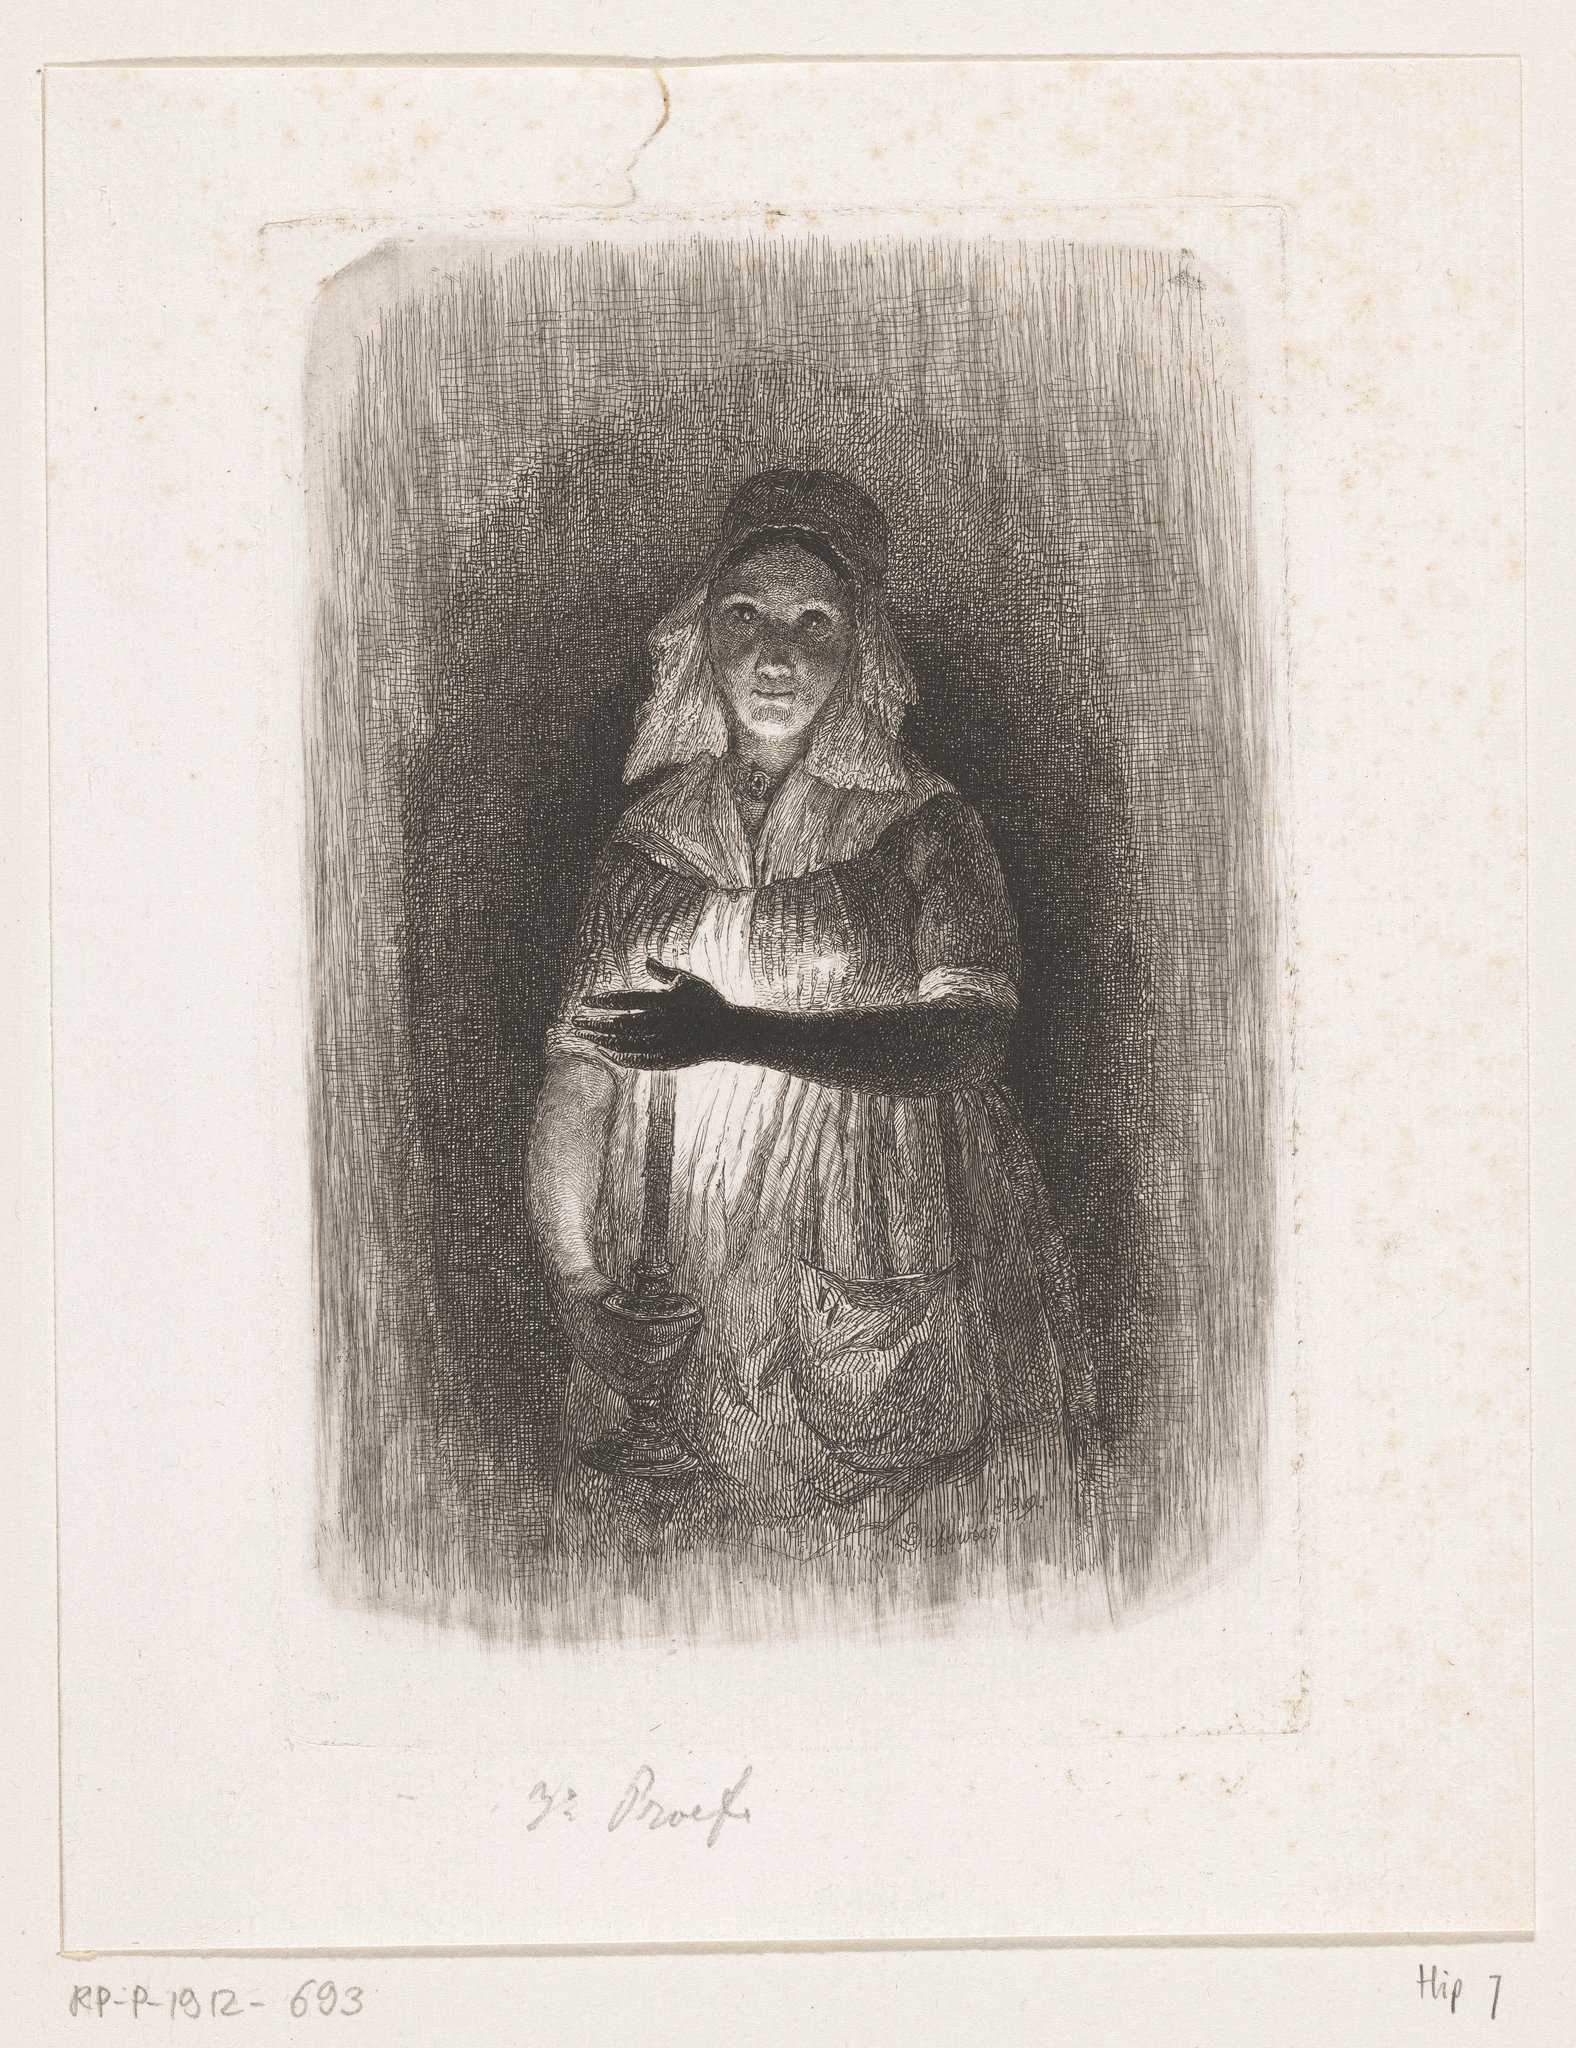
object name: print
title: Dienstmeisje met brandende kaars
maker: pierre louis dubourcq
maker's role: draughtsman, painter, print maker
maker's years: 1815-1873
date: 1839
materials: paper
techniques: drypoint, etching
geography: netherlands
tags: maid ~ house personnel, chandelier, candelabrum (+ kindling a light; lit, burning light, lamp, candle)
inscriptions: collector's mark: Lugt 2228